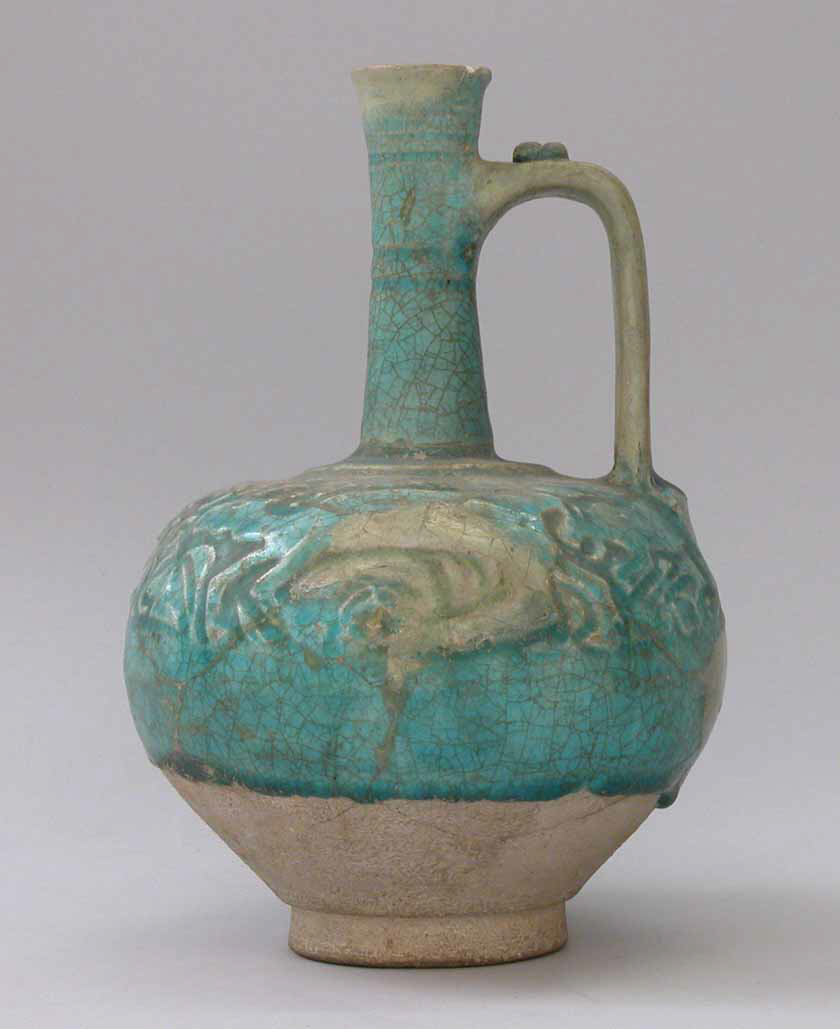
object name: ewer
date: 1101-1300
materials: stonepaste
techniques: glazing, molding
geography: iran